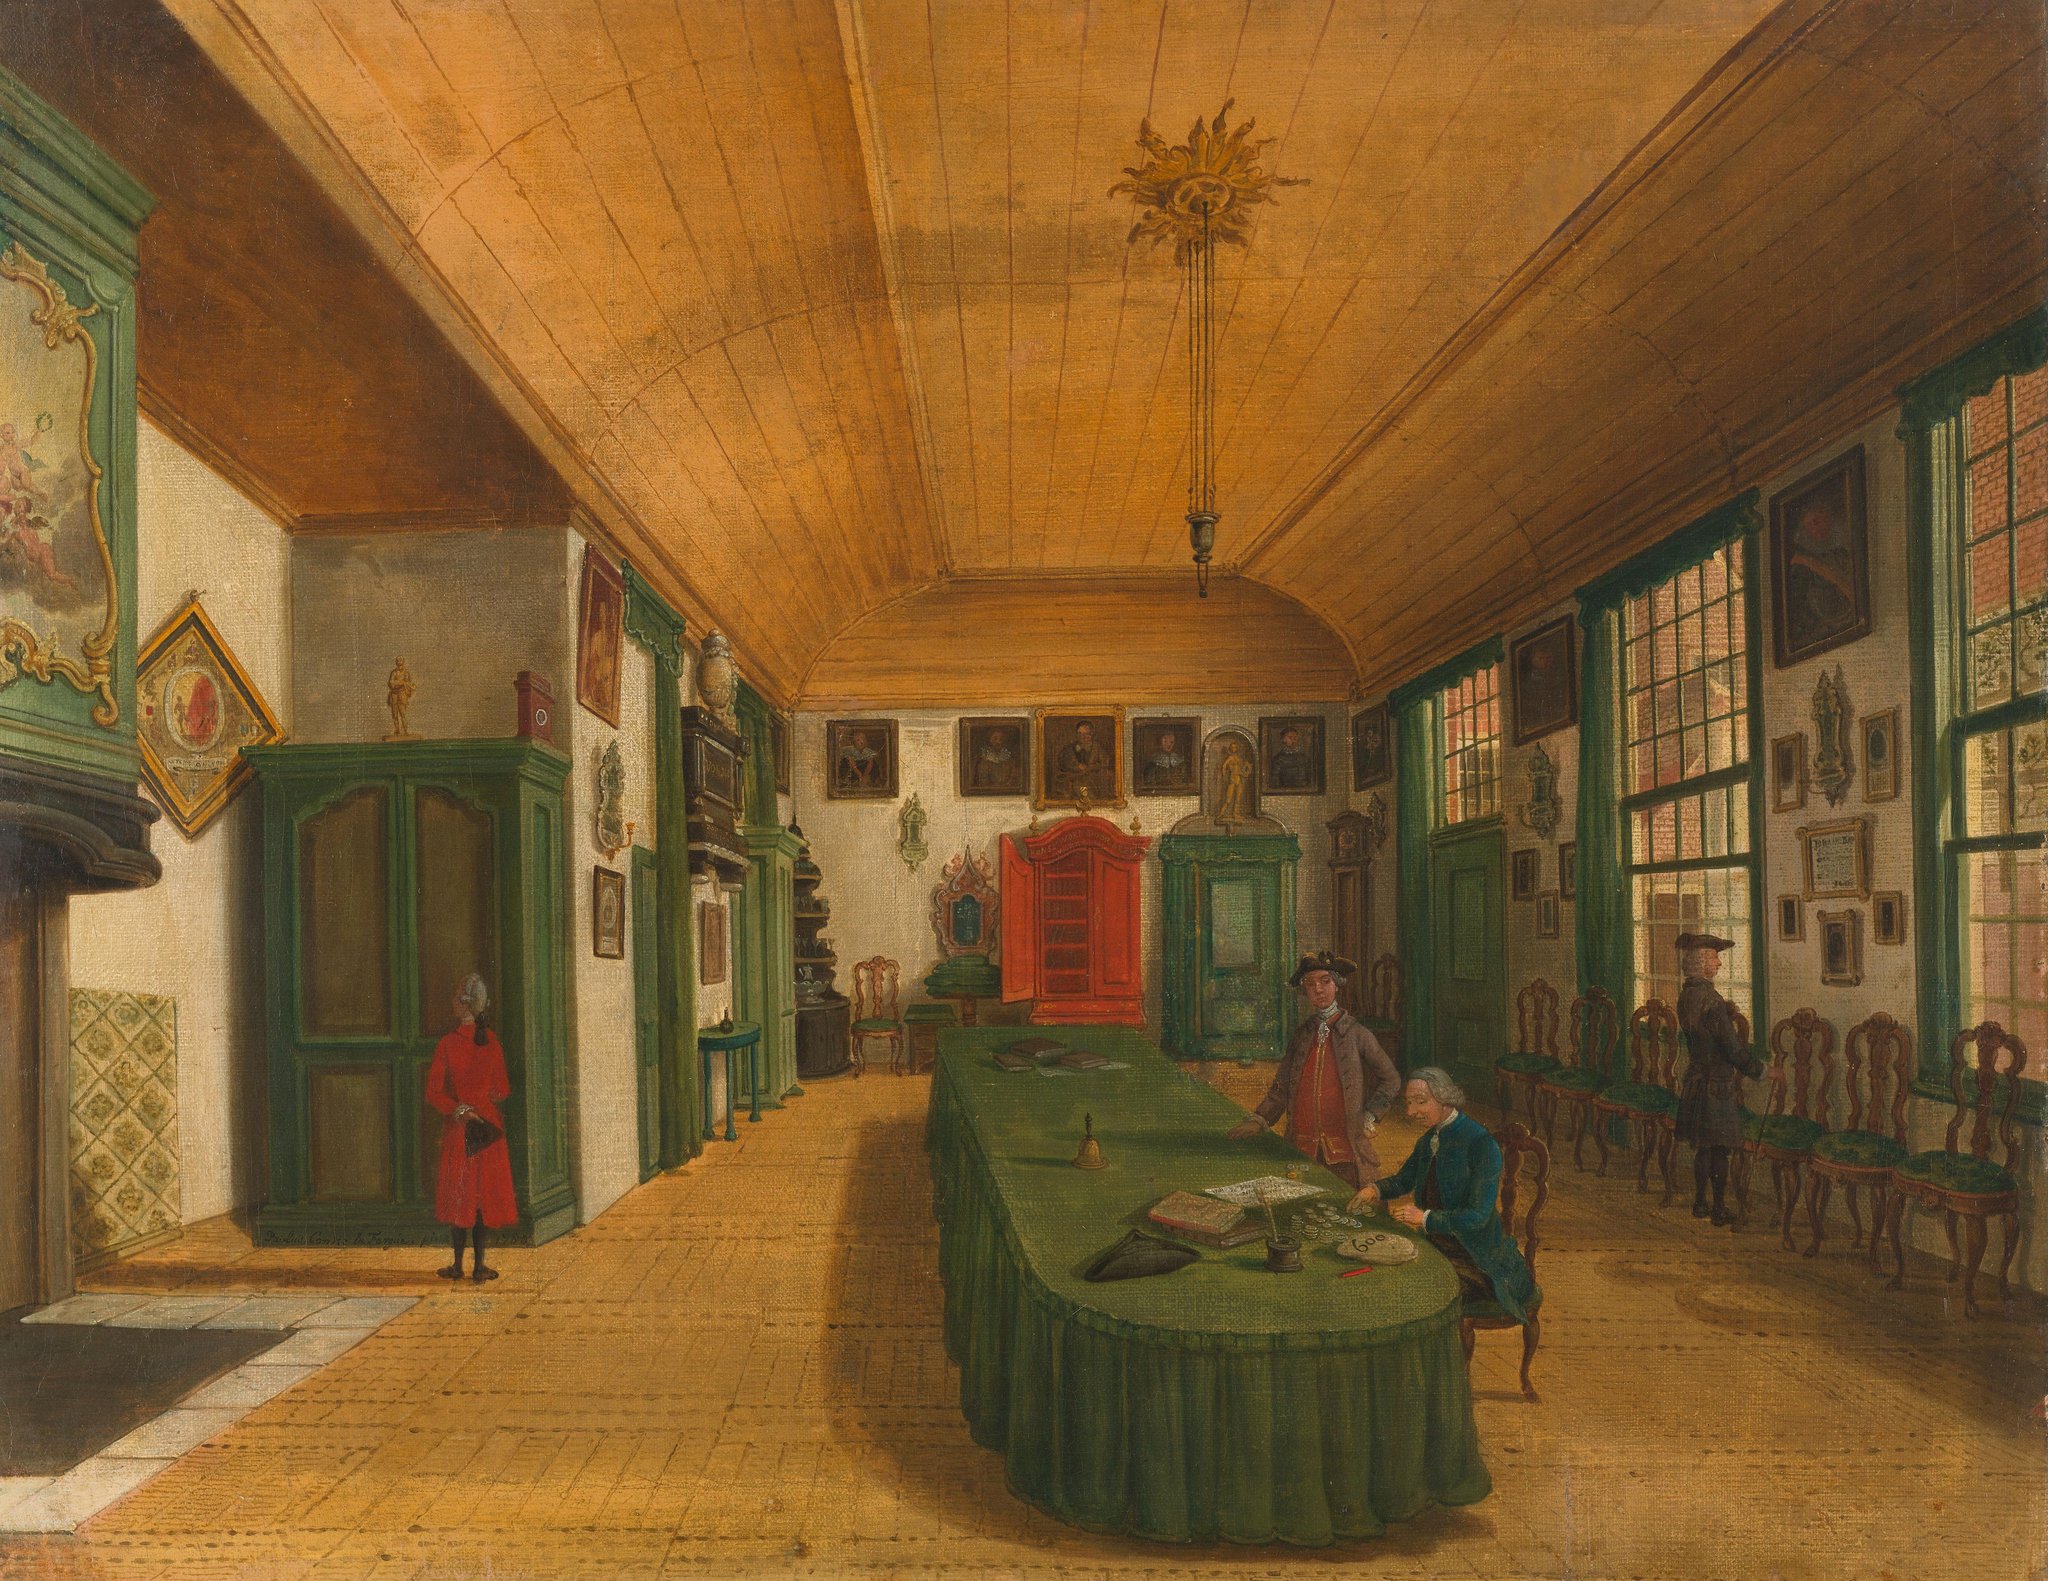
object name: painting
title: The Hall of the Artistic Society 'Kunst wordt door Arbeid verkregen' (Art is Acquired through Labor) in Leiden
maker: paulus constantijn la fargue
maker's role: draughtsman, painter, print maker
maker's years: 1729-1782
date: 1780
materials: canvas, oil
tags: learned society, academy of sciences, academy, association of artists, leiden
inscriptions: signature and date: ‘Paulus Const. la Fargue pinx. 1780’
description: Interieur van de zaal van het genootschap 'Kunst wordt door Arbeid verkregen' te Leiden. Ruime zaal met in het midden een lange tafel waaraan de penningmeester van het genootschap geld zit te tellen. Links en rechts wandelen bezoekers door het vertrek. Aan de muren hangen schilderijen, links een rederijkersblazoen, aan de rechterzijde een rij stoelen voor de vensters.